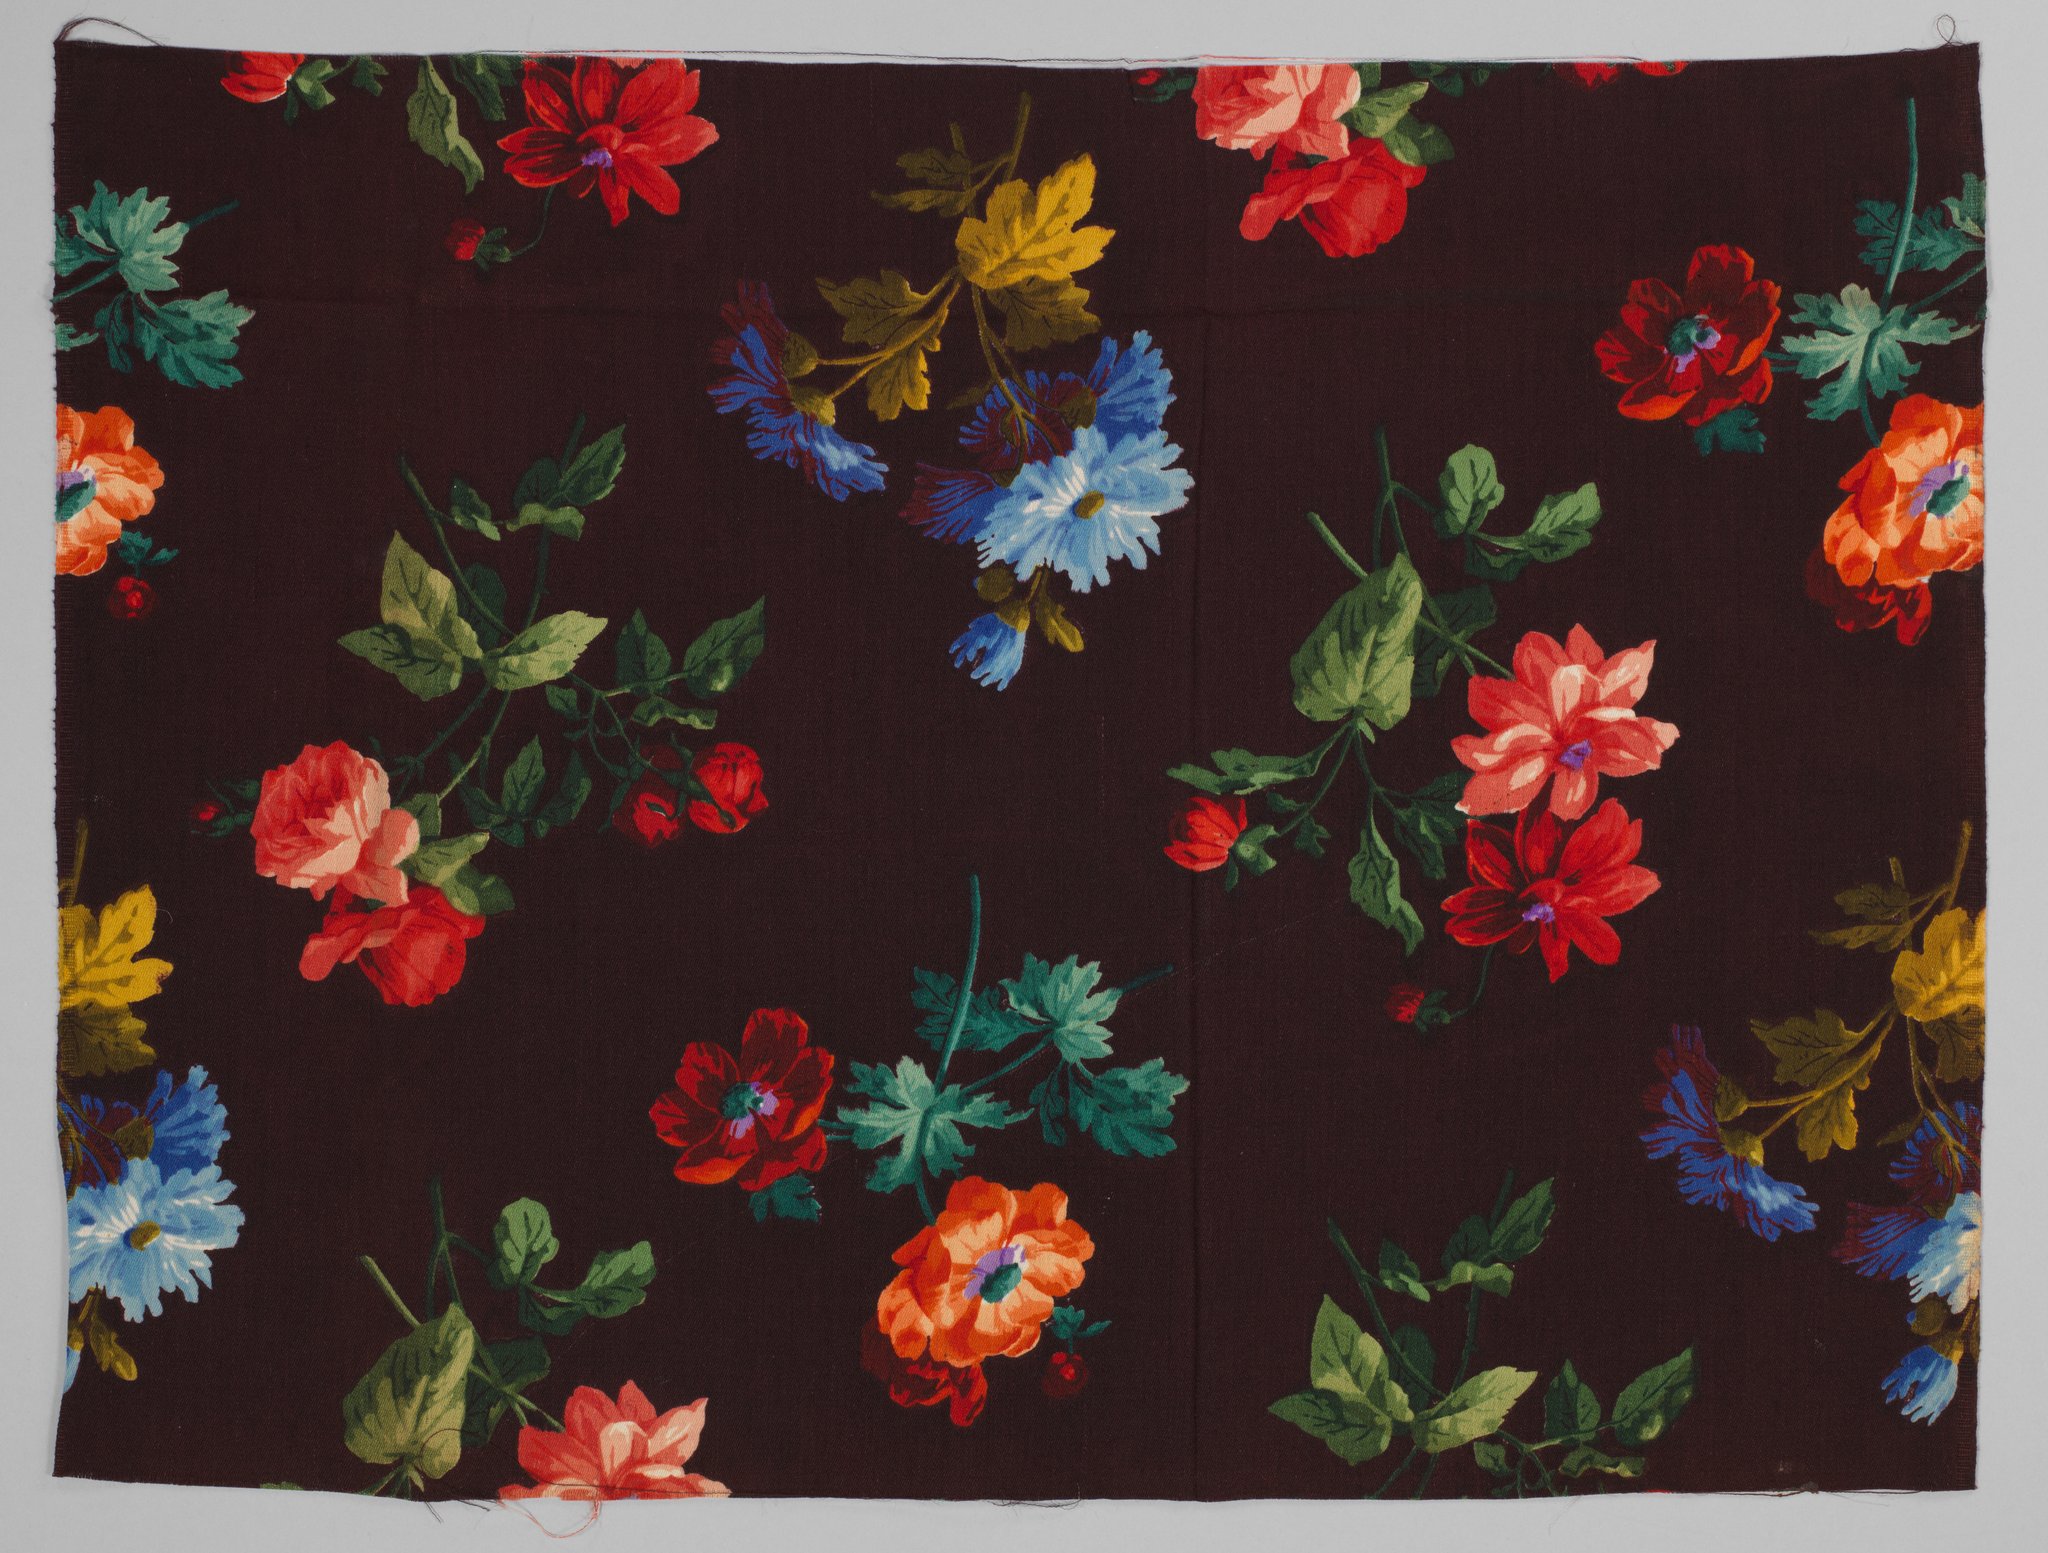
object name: piece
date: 1860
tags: flowers